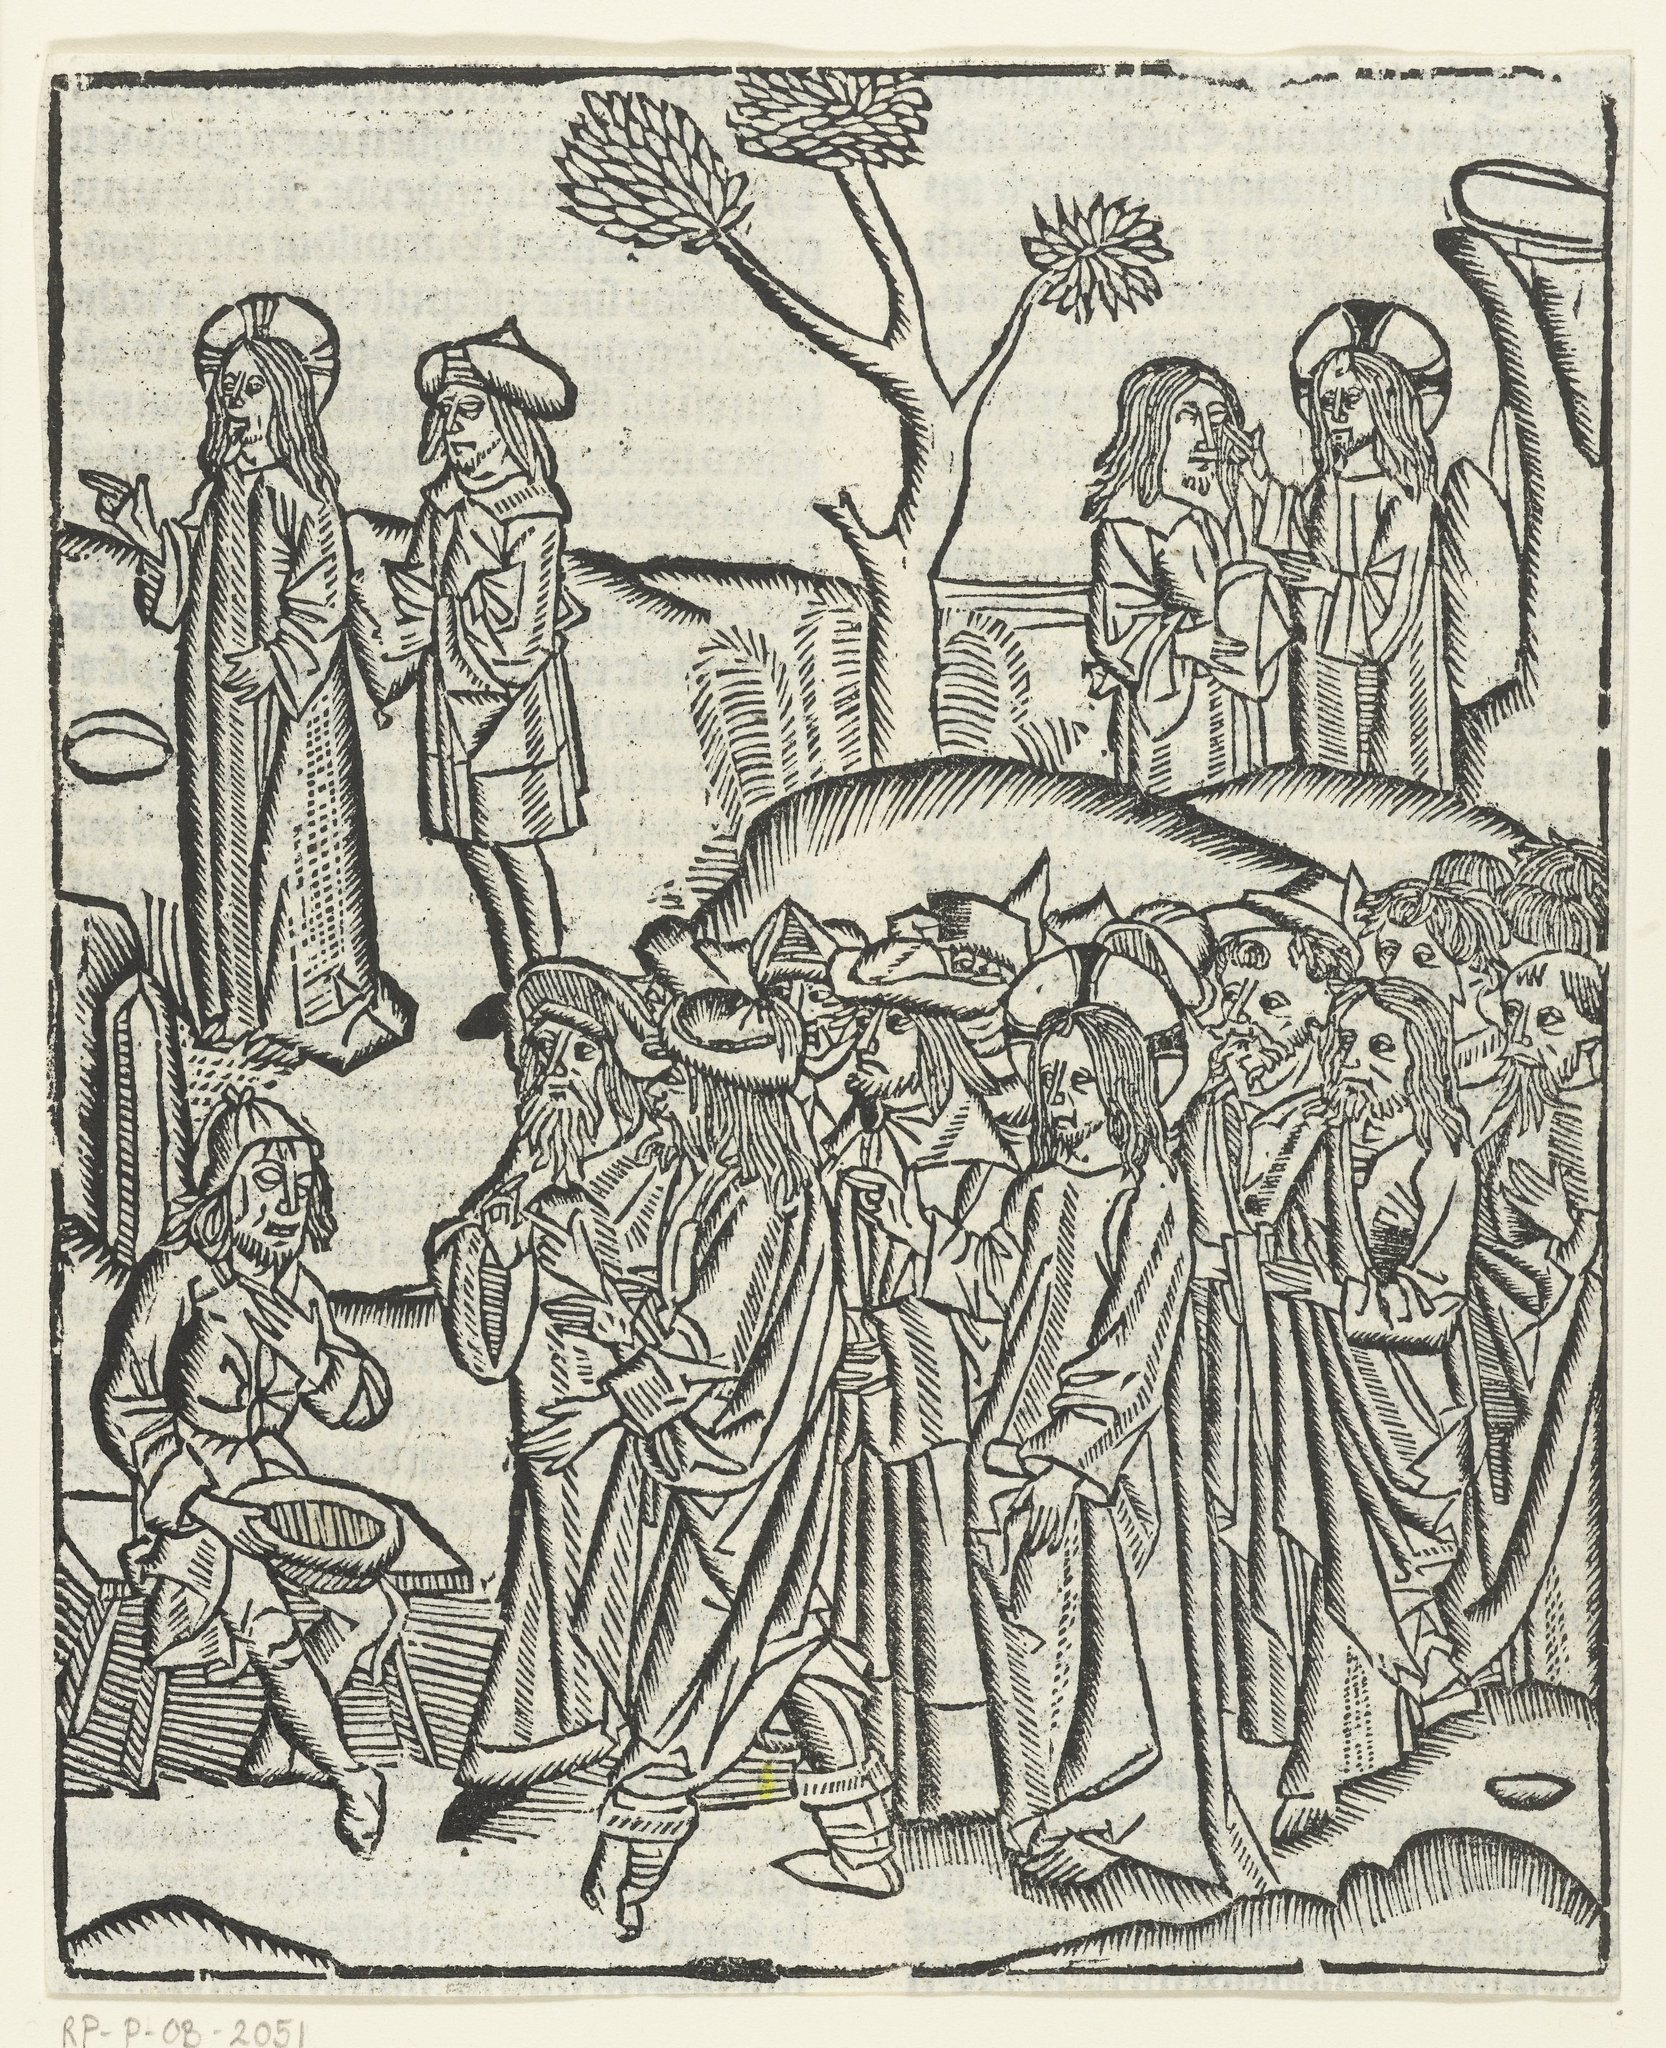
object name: book illustration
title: Christus geneest de blinde Bartimeus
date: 1480-1500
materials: paper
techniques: woodcut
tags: healing of two blind men, or one (bartimaeus), sitting near jericho (matthew 20:29-34; mark 10:46-52; luke 18:35-43)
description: Eén blad van 113 uit Ludolphus de Saxonia, "Dit es dleué ons liefs heeren ihesu christi". Anonieme Nederlandse vertaling. Uitgegeven door Henrick Eckert van Homberch te Antwerpen in 1503. Botke, K. Deze 113 houtsneden, die meestal reeds in vroege Nederlandse boeken gebruikt zijn, worden toegeschreven aan de tweede Meester van Delft, de Meester van de Delbecq-Schreiber-passie en de Meester van de Virgo inter Virgines. In Conway (1884) en in "De gulden passer"(1951) zijn ook eerdere versies opgenomen. Botke, K.